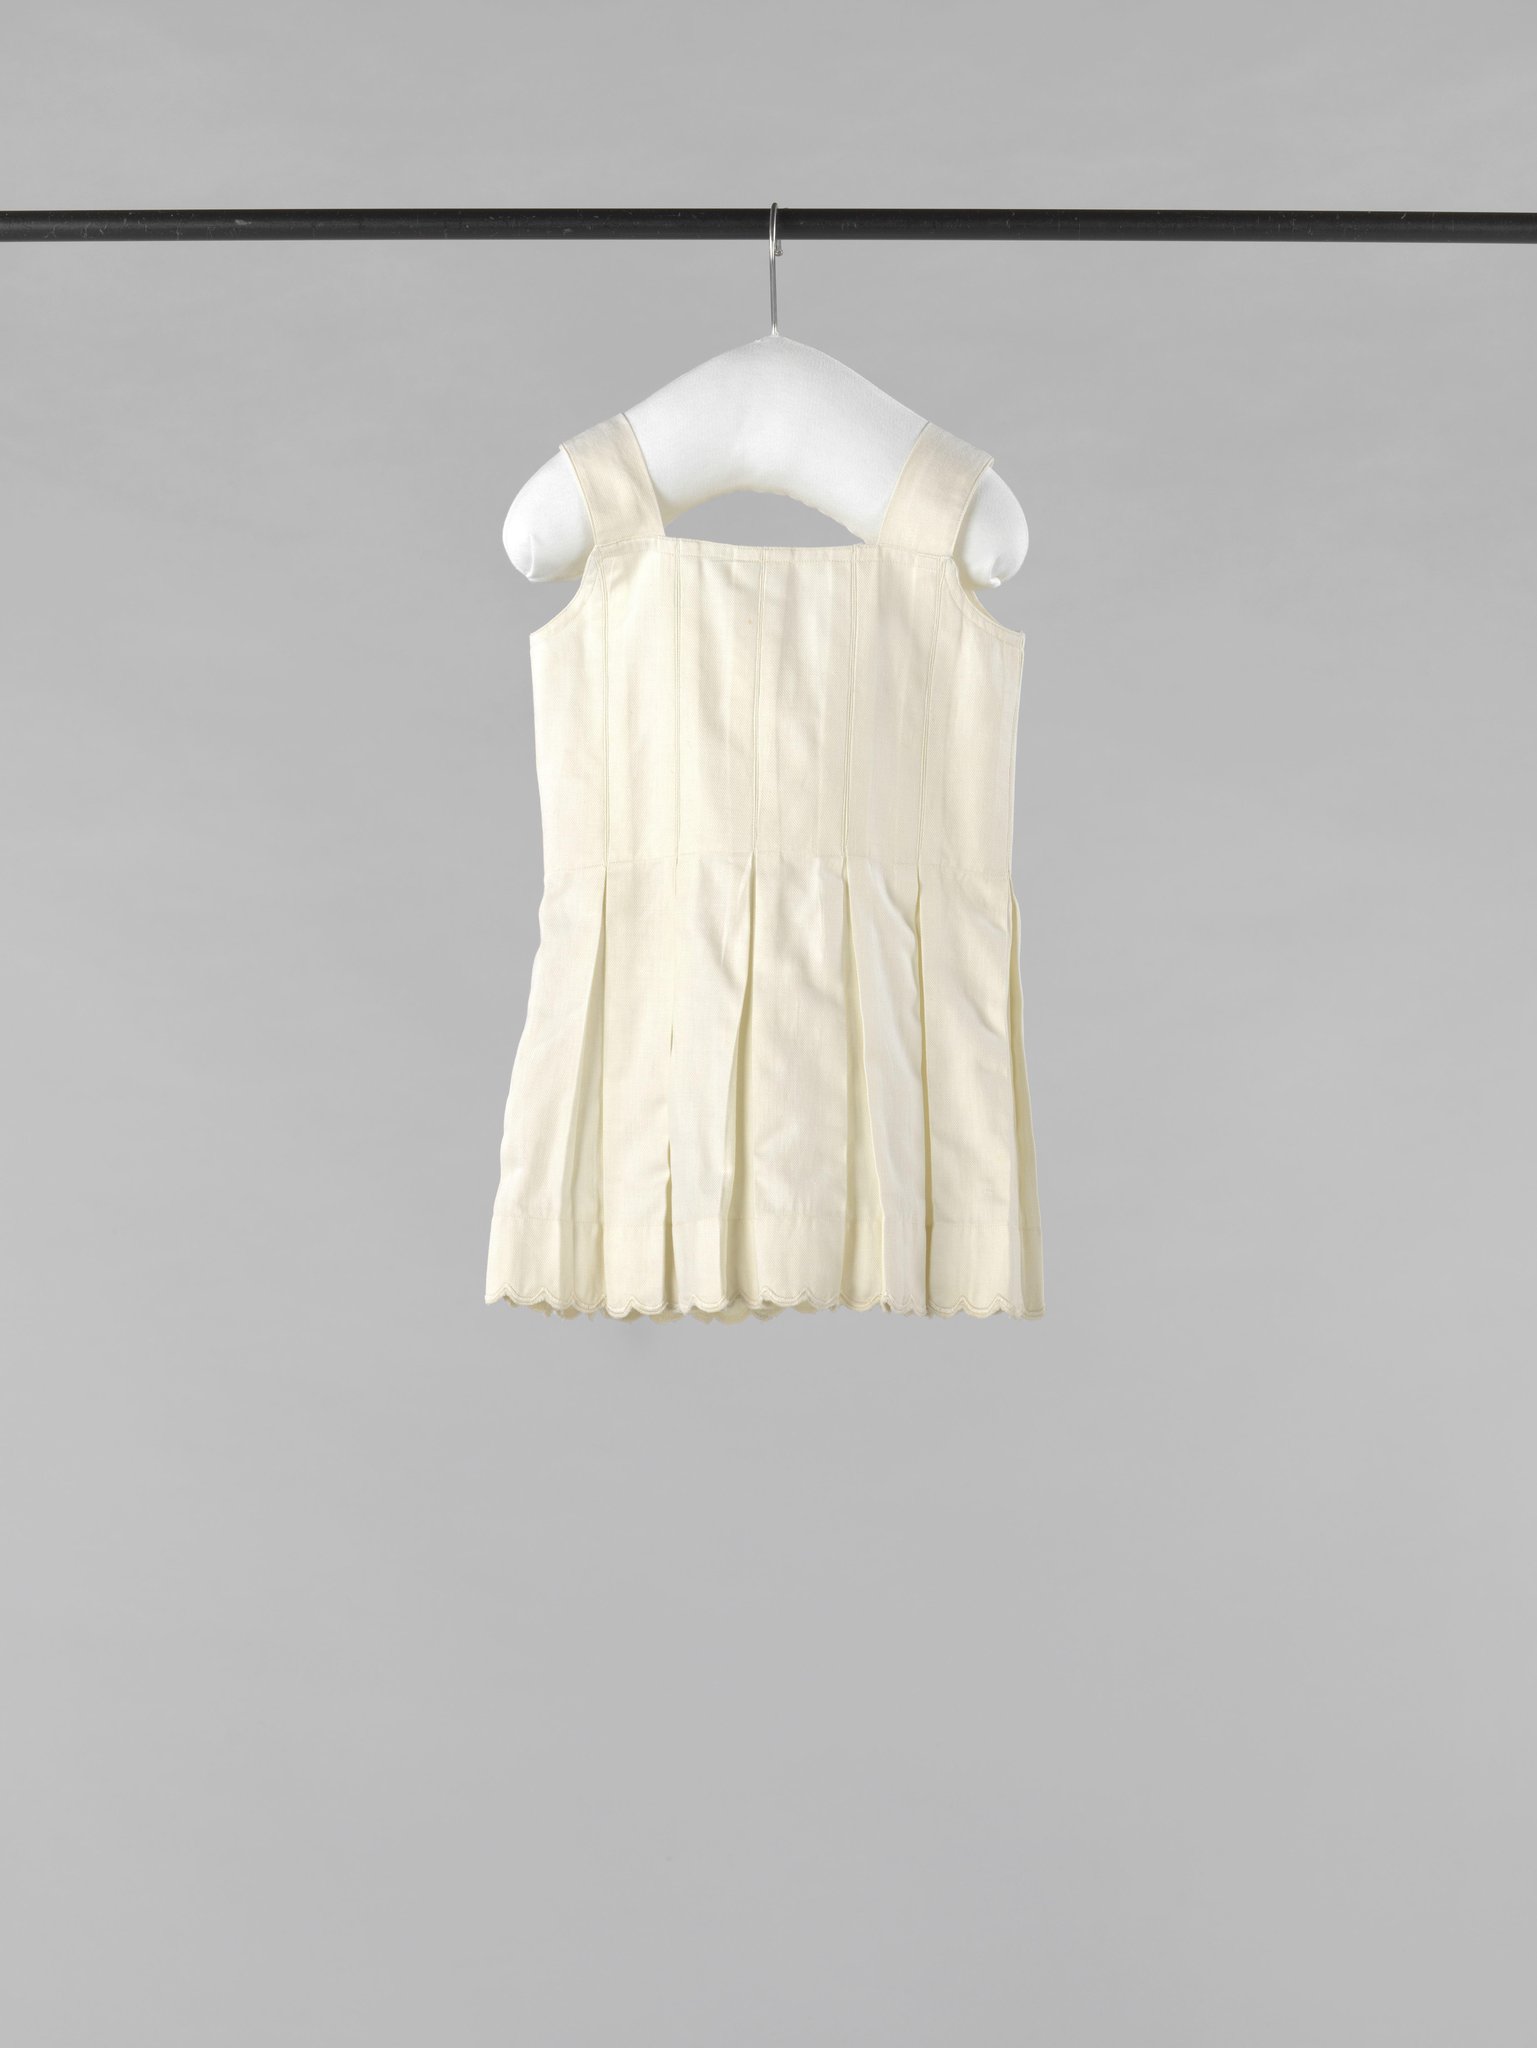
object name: robe, japon, jurk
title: Mouwloze kinderjurk of apenrok van witte keperkatoen met lijf van dichtgestikte platte plooien en achtersluiting met drie strikken, geschulpte zoom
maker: Anonymous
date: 1930-1935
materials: cotton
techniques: weave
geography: vught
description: Mouwloze kinderjurk of apenrok van keperkatoen met lijf van dichtgestikte platte plooien en achtersluiting met drie strikken, geschulpte zoom. Model: baan keperkatoen van 40 cm hoog is geheel geplooid met platte plooien, die voor het lijf zijn vastgestikt en voor de rok open zijn geglaten. Brede schouderbanden. Sluiting middenachter door middel van drie biais striklinten. Geschulpte zoom, die machinaal voorzien is van een sierrand van glanzend wit garen waarna de overtyollige stof is weggeknipt.